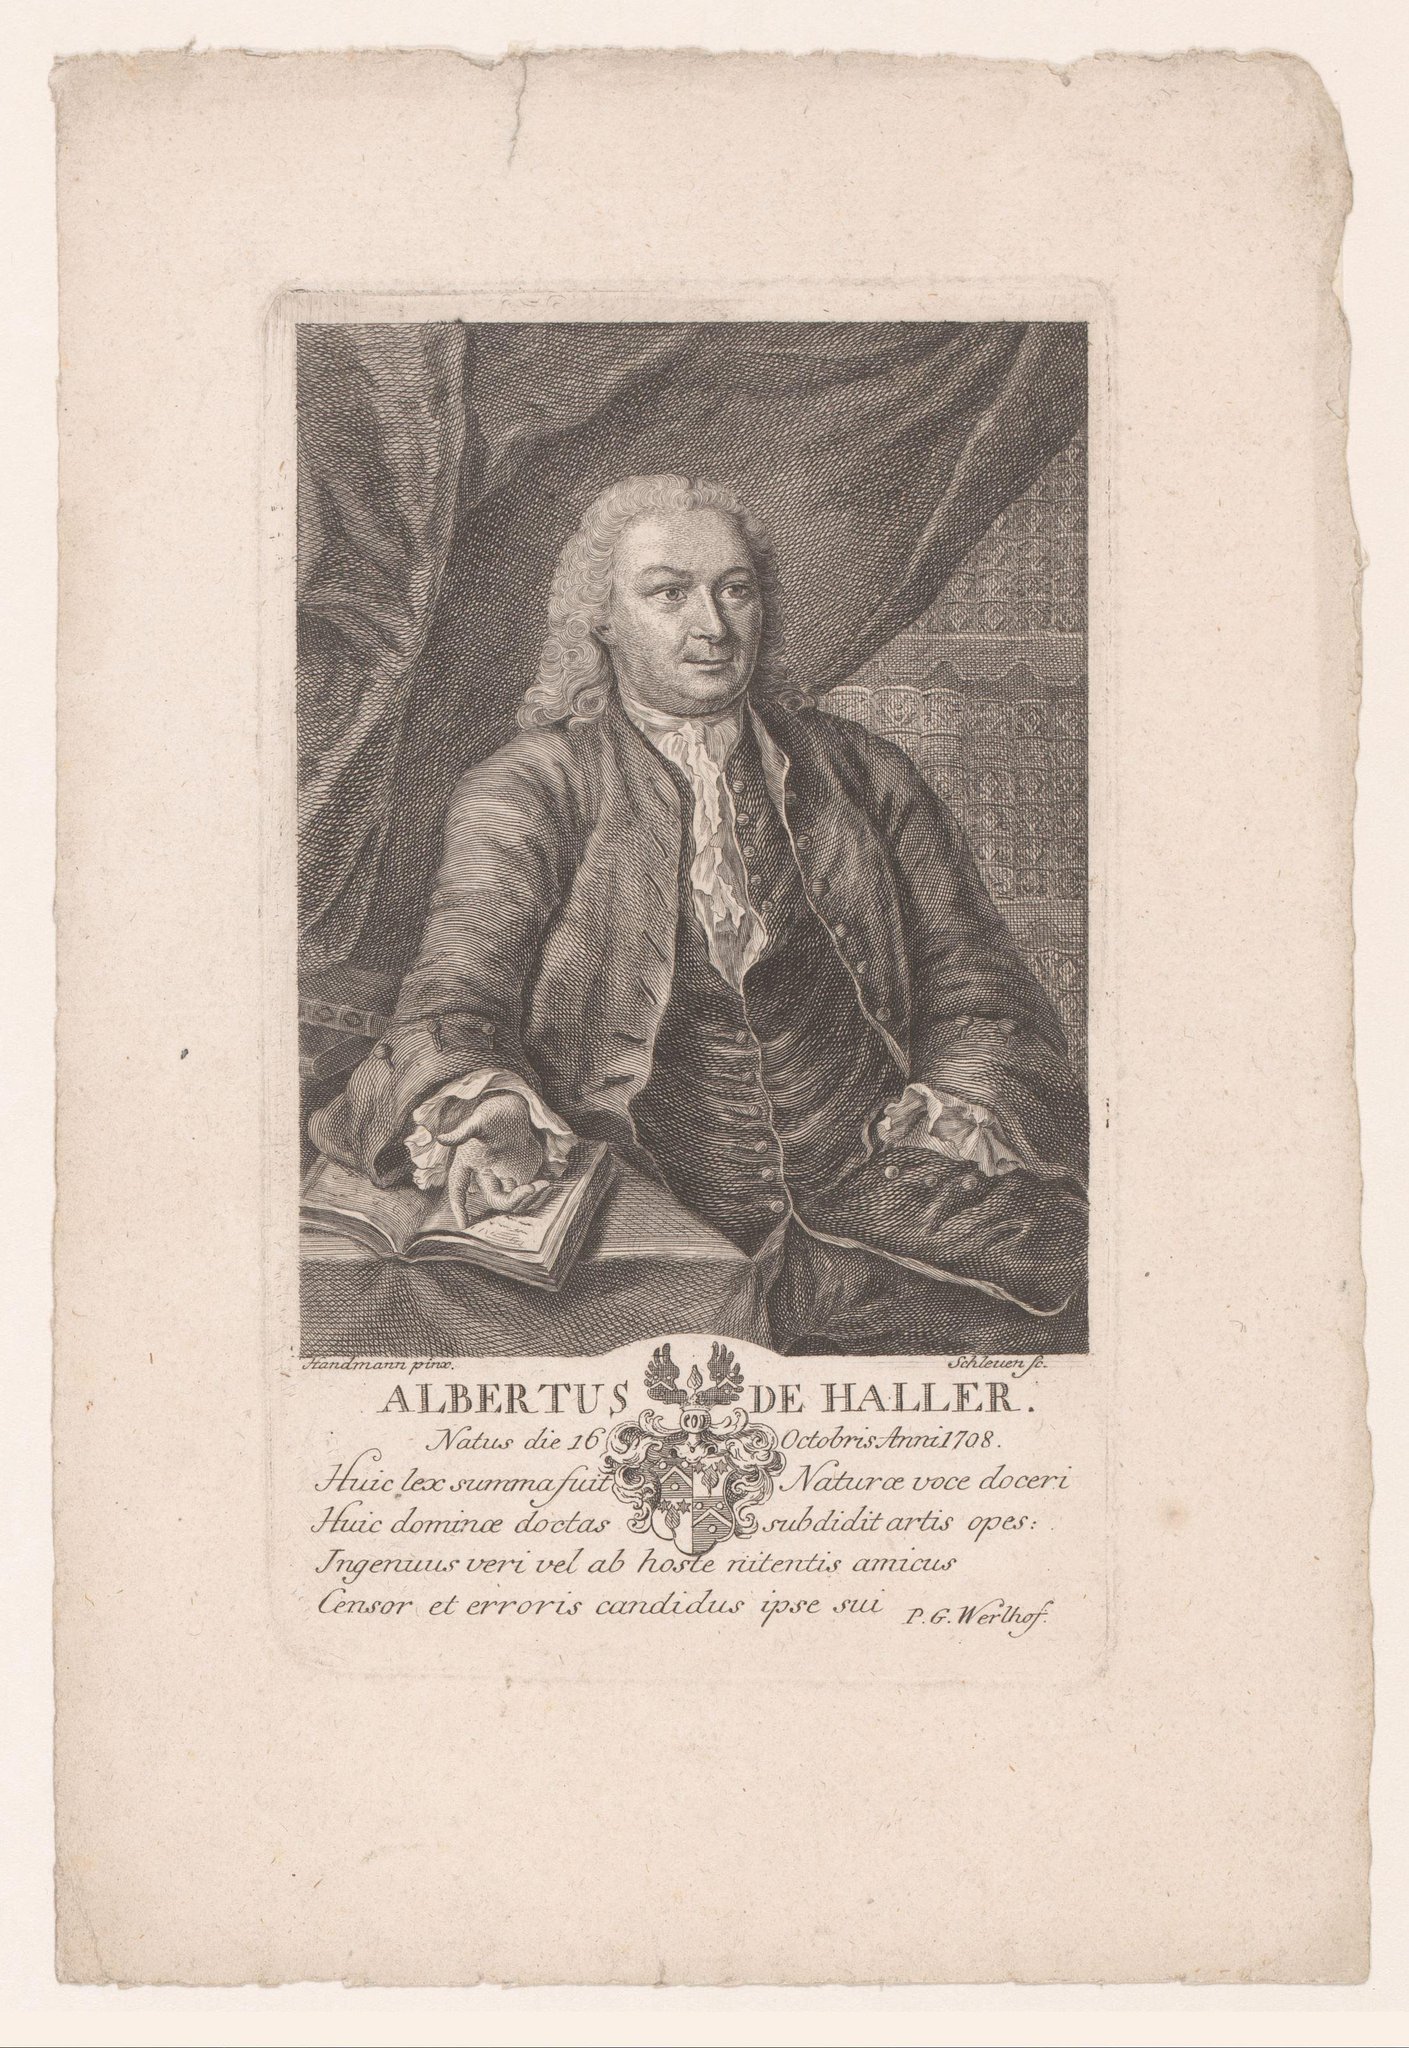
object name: print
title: Portret van Albrecht Haller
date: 1749-1784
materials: paper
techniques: engraving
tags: physicist, historical persons, armorial bearing, heraldry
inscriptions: collector's mark: Lugt 2228